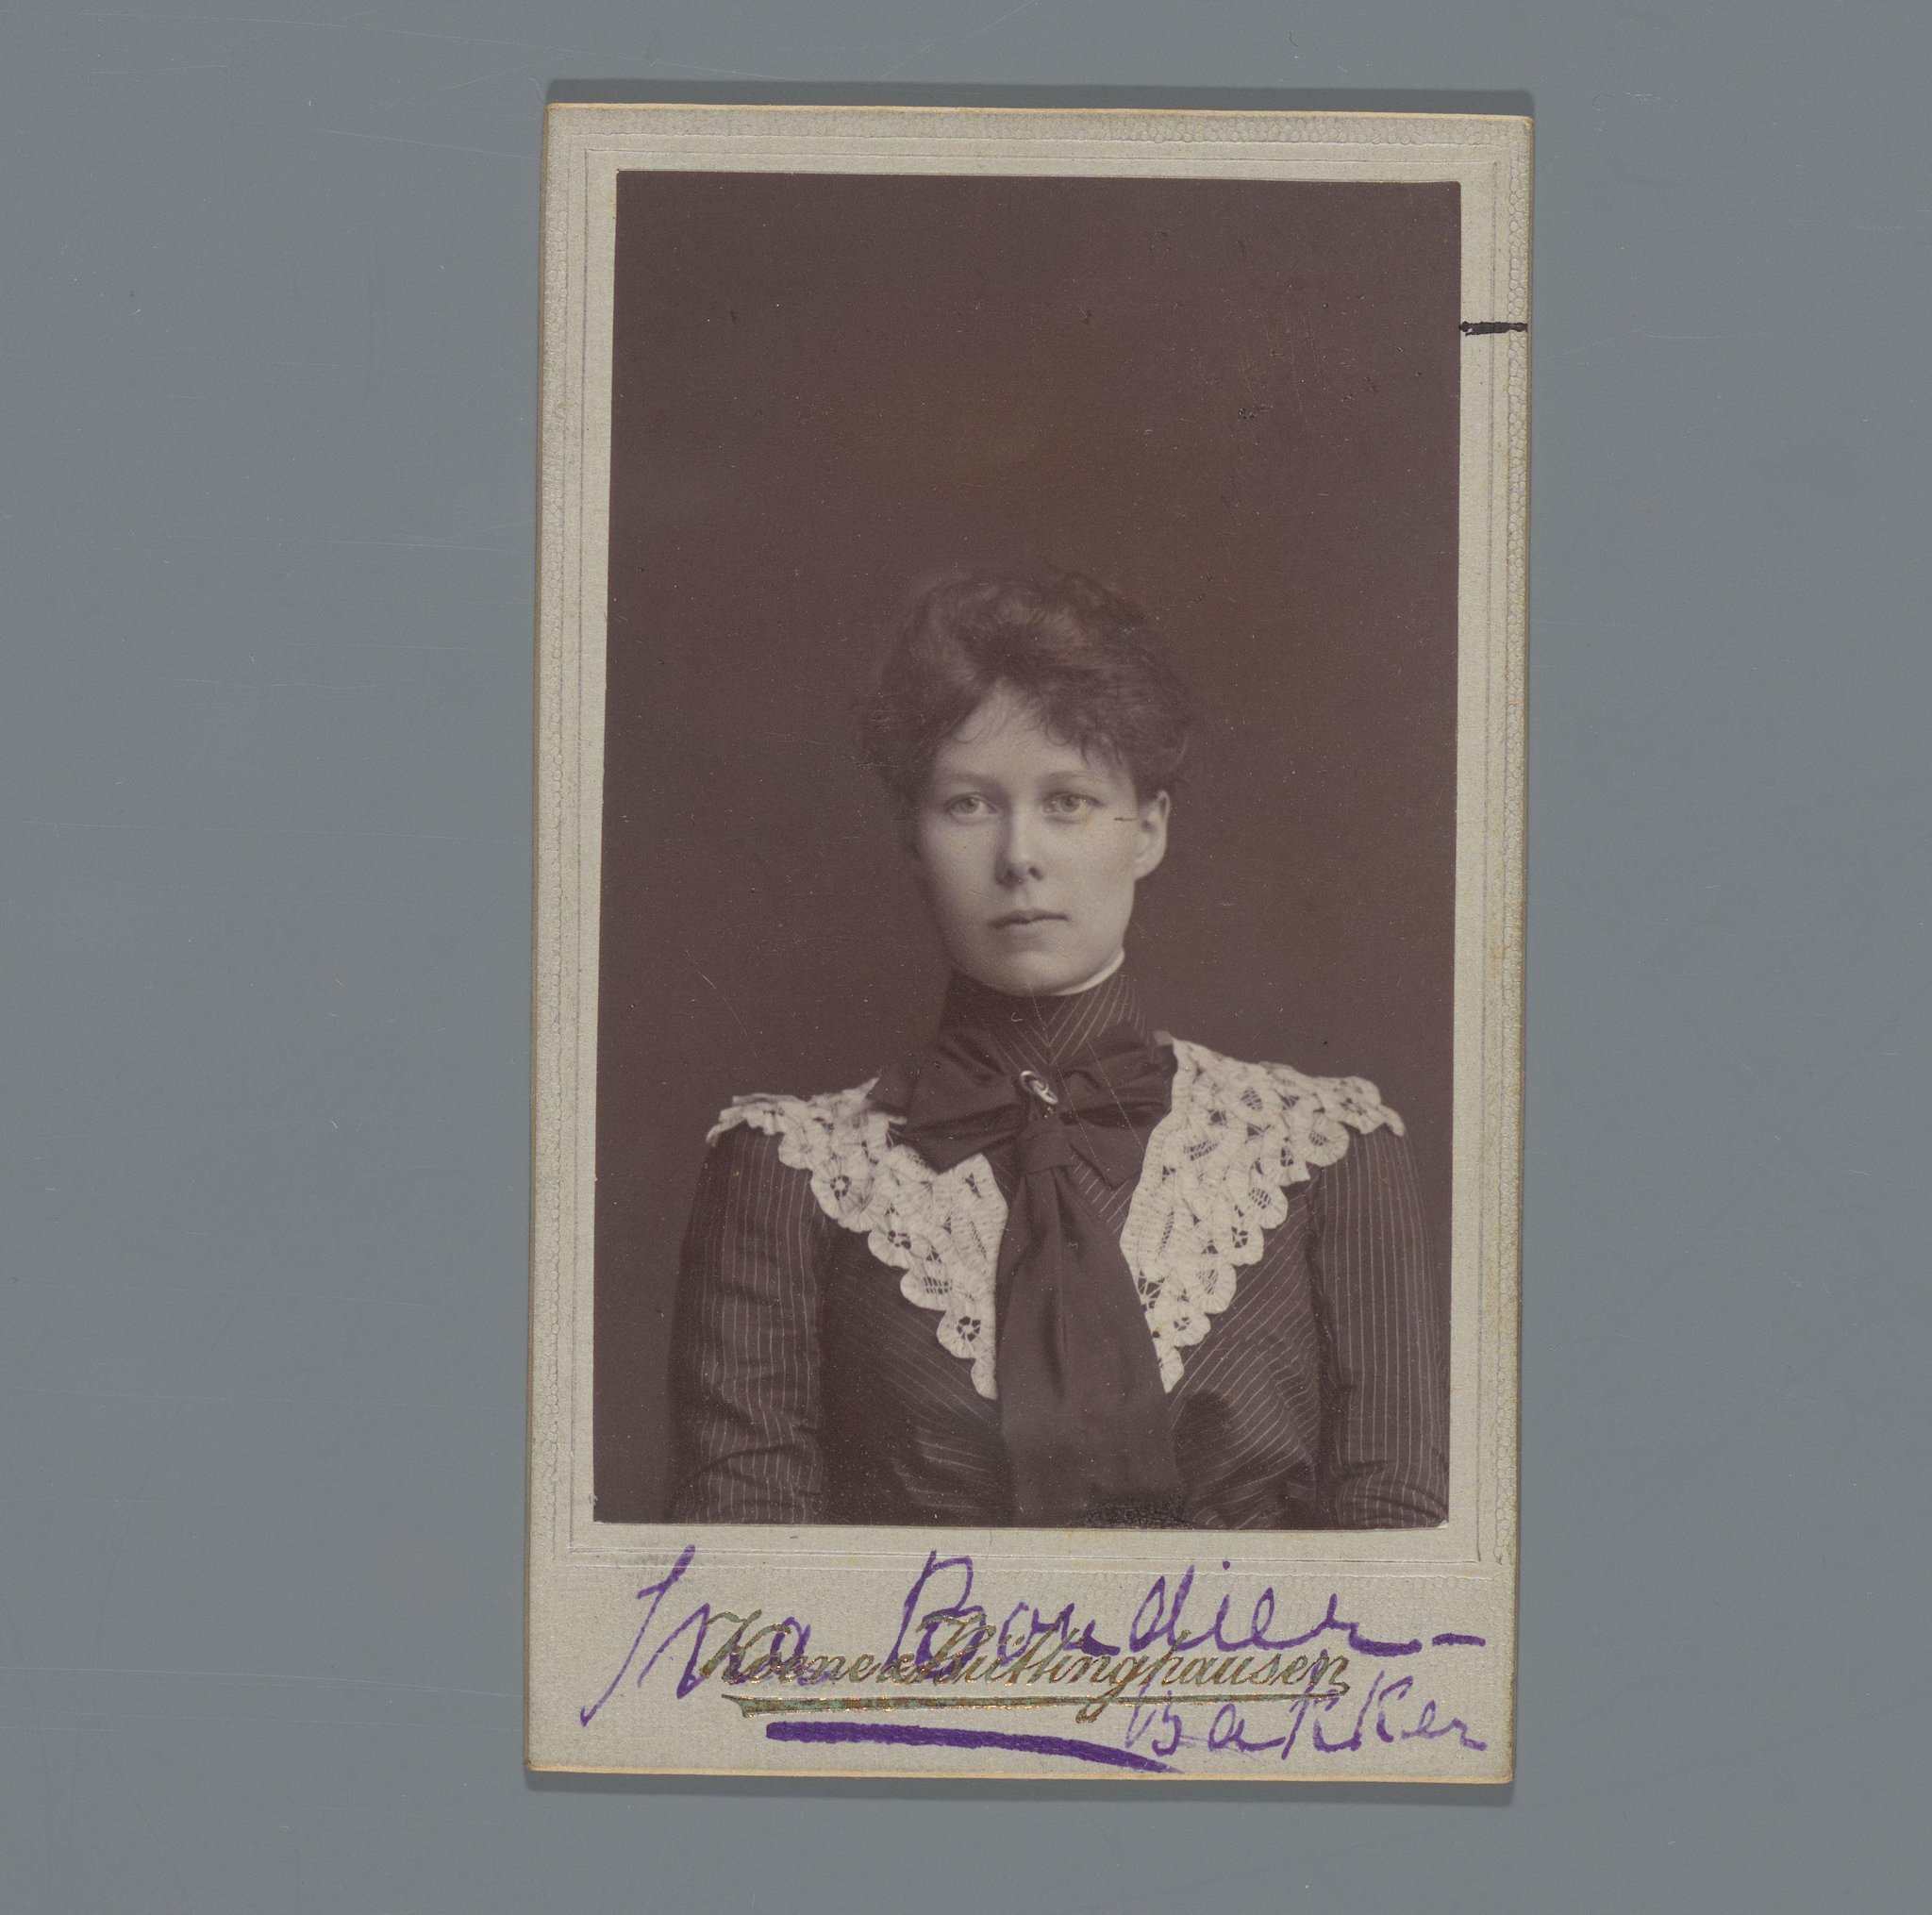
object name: carte de visite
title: Portret van Ina Boudier-Bakker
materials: cardboard, photographic support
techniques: matte daylight collodion silver print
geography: amsterdam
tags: utrecht, ina boudier-bakker, portrait of a writer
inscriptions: name: ‘Ina Boudier-/ Bakker’, number: ‘4402’, collector's mark: Lugt 2228a, inscription: ‘Koene & Büttinghausen/ Amsterdam/ Heerengracht 150/ TELEPHOONNUMMER 1402/ BATAVIA/ PRAGER & Ljoda, Berlin/ 17203.’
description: Foto gebruikt als auteursportret voor: De Hollandsche Lelie, februari 1904.